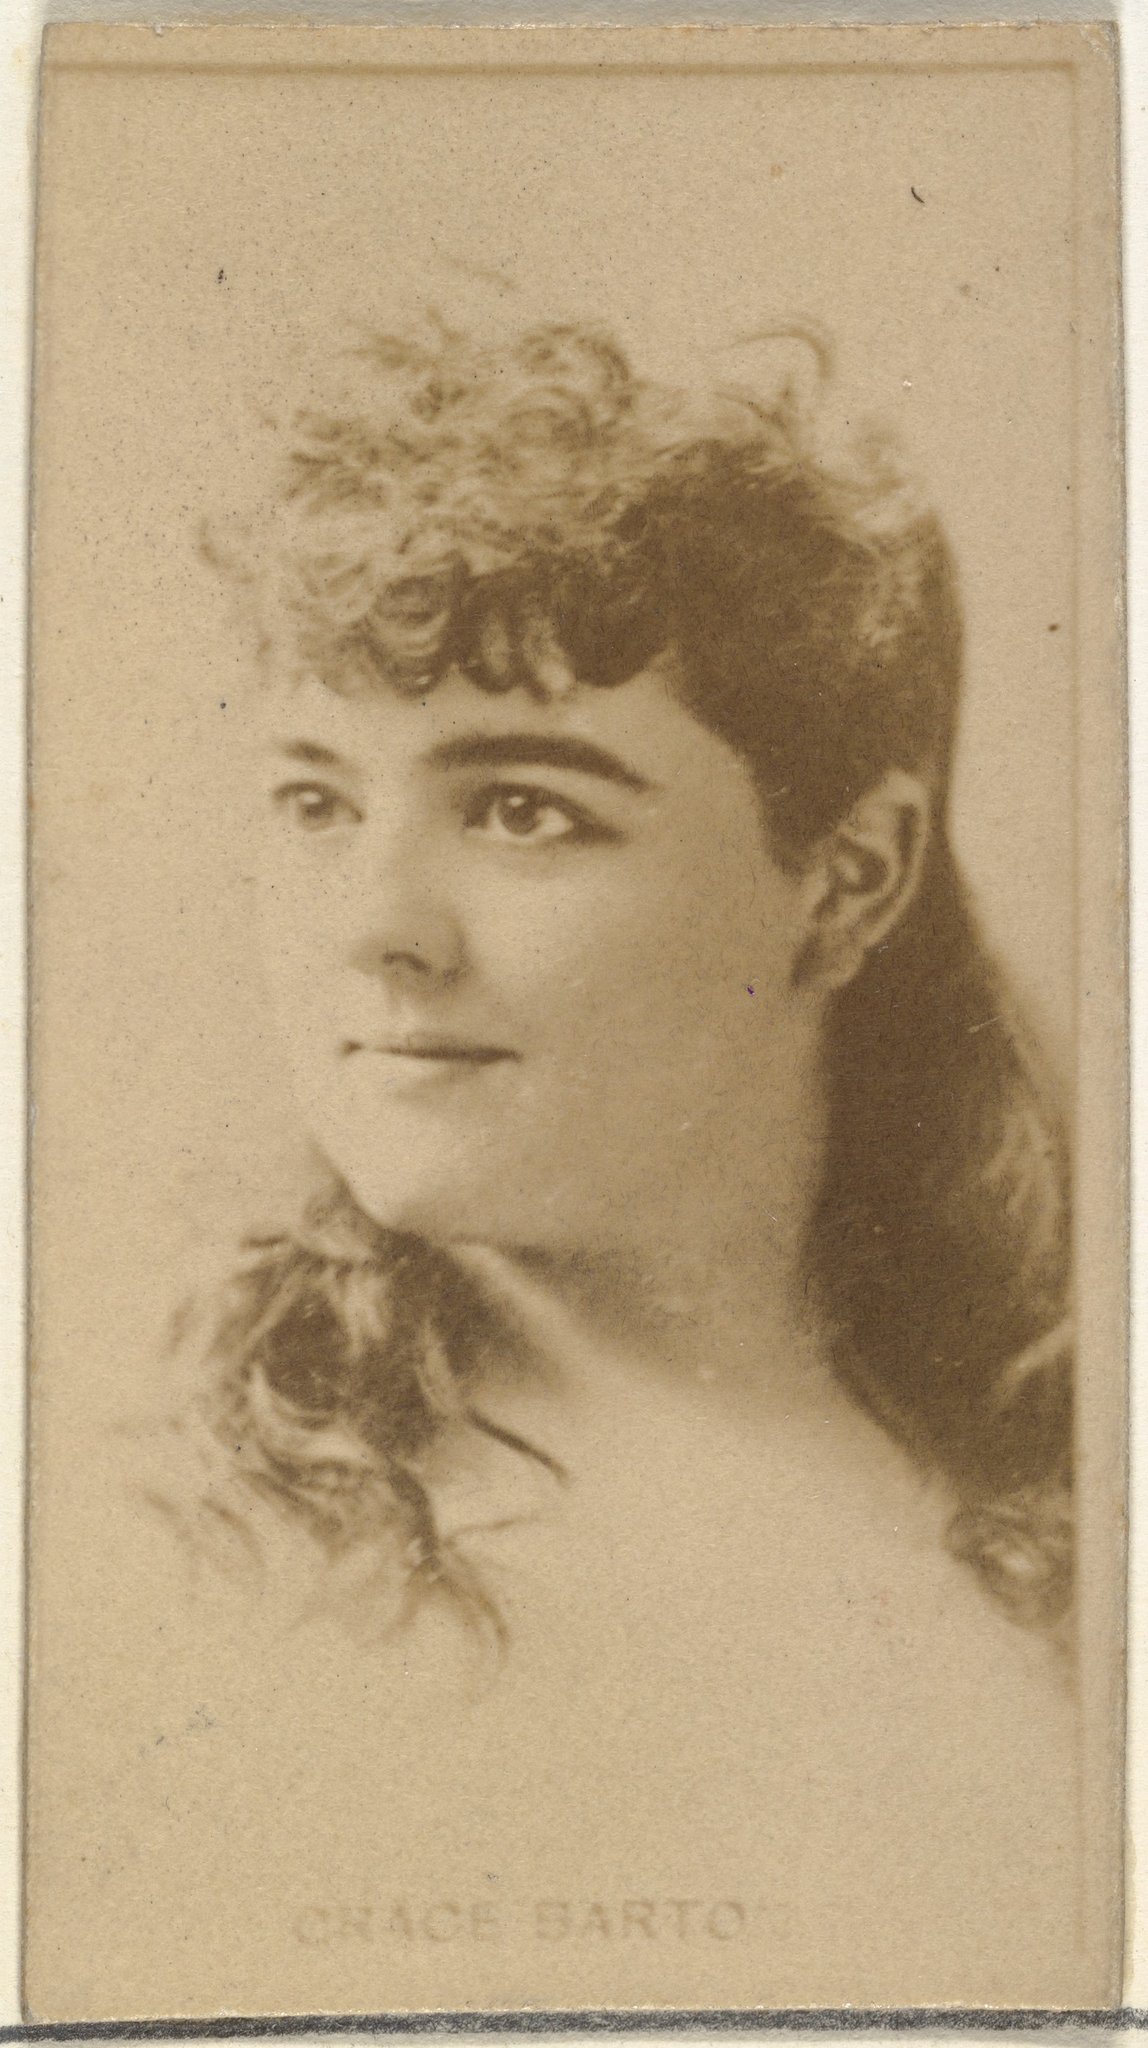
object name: photograph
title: Grace Barton, from the Actors and Actresses series (N145-8) issued by Duke Sons & Co. to promote Duke Cigarettes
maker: w. duke, sons & co.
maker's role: publisher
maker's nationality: american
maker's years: 1870-1920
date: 1891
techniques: albumen silver print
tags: portraits,women,actresses